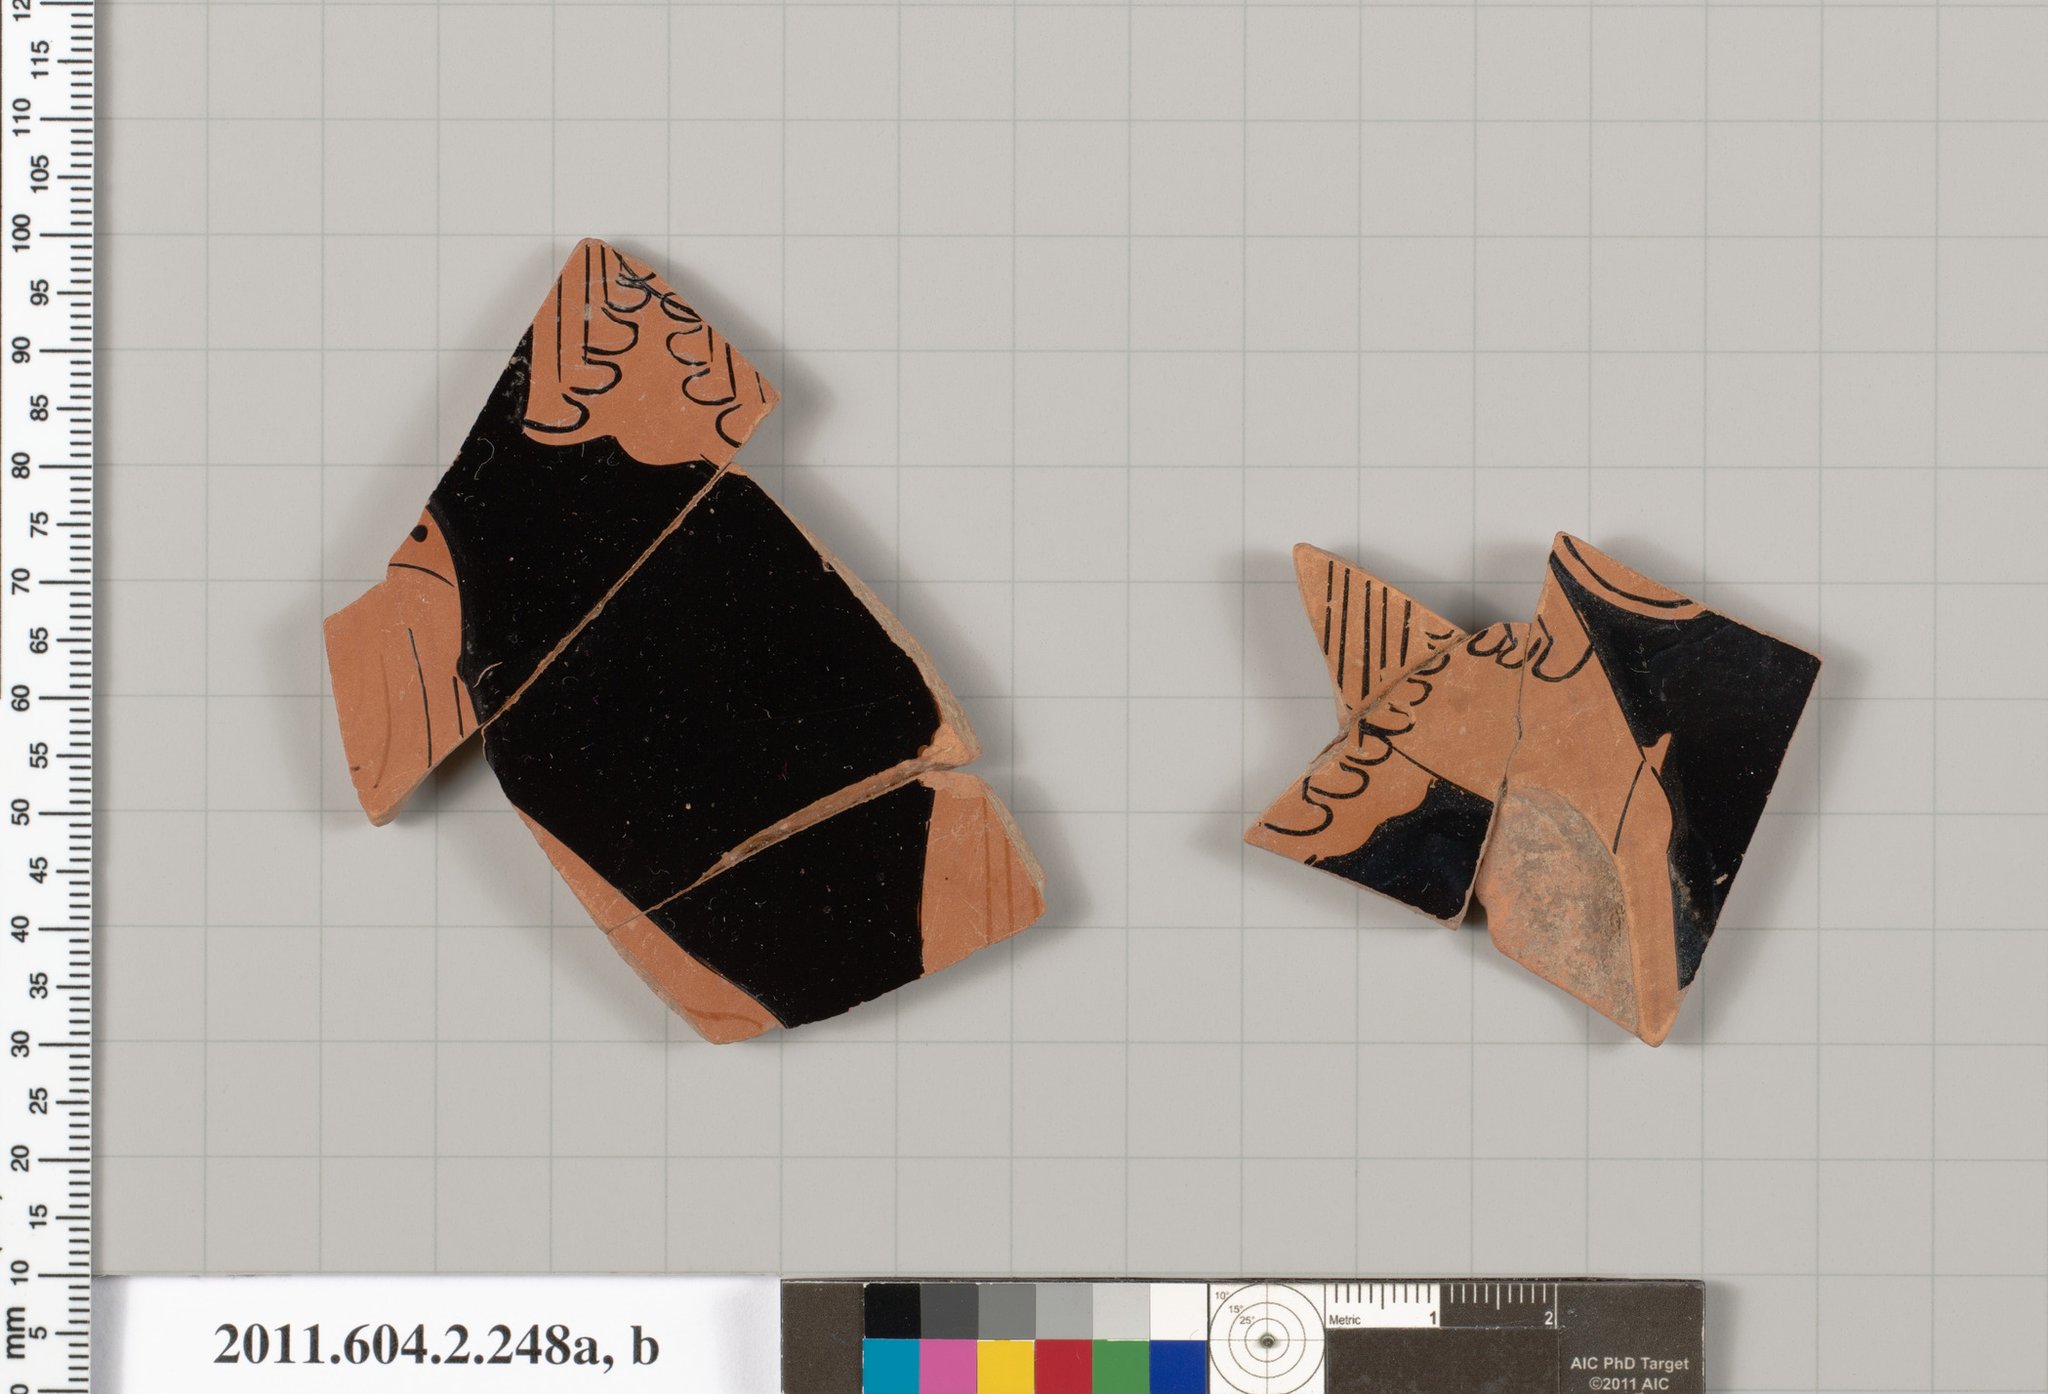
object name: stamnos fragment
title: Terracotta fragments of a stamnos (jar)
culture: greek, attic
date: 500-476 BCE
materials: terracotta